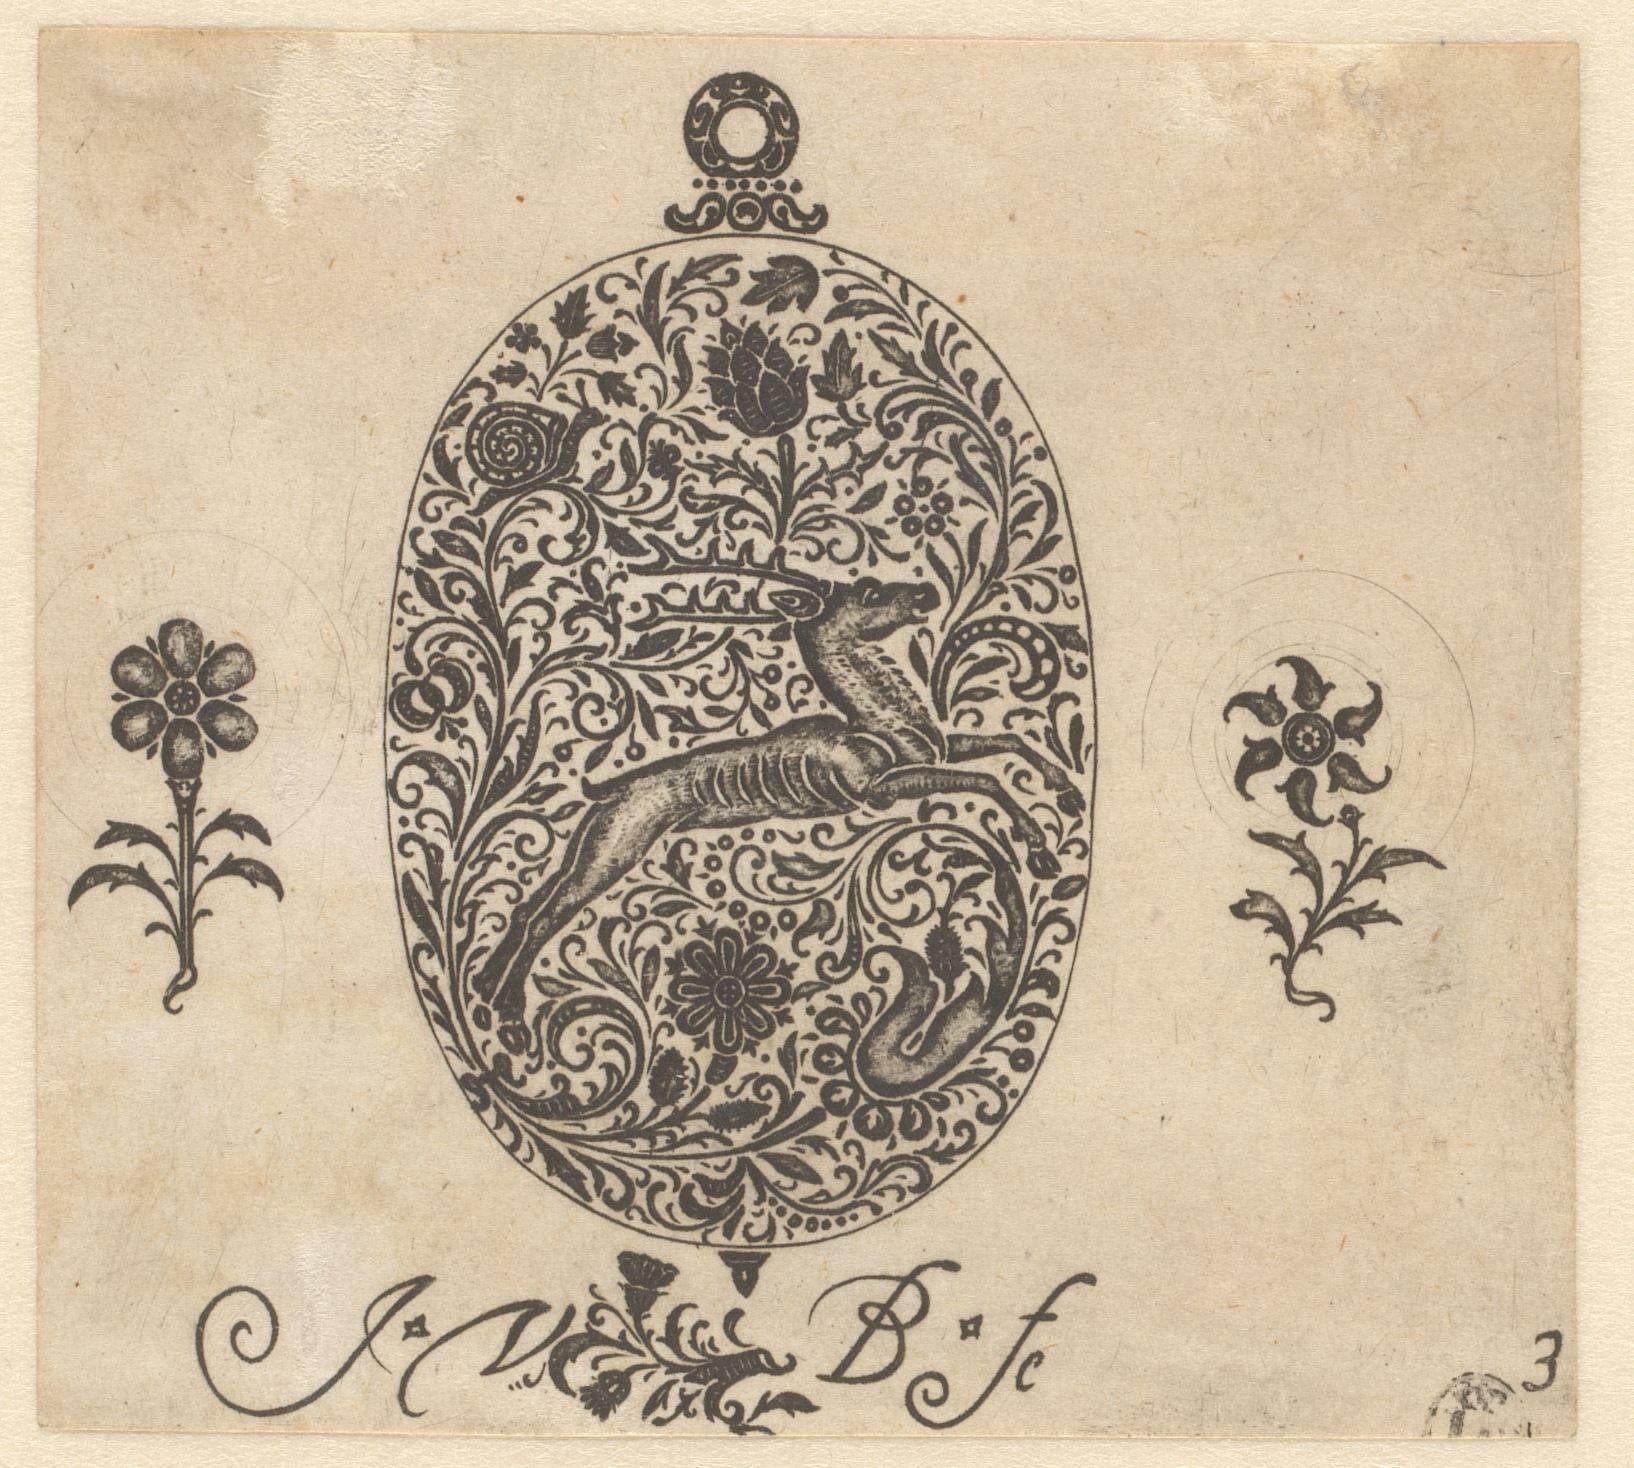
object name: ornament print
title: Zwartornament met dichte, fijne bladerranken, bloemen, een hert en een slak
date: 1619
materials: paper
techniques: engraving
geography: amsterdam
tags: ornaments ~ art, hoofed animals: deer, molluscs: snail, foliage, tendrils, branches ~ ornament, flowers ~ ornament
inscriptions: collector's mark: Lugt 972, collector's mark: Lugt 2760, number: ‘3’, collector's mark: Lugt 2228, signature: ‘J.vB. fe.’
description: Een blad uit een serie van ontwerpen voor sieraden.